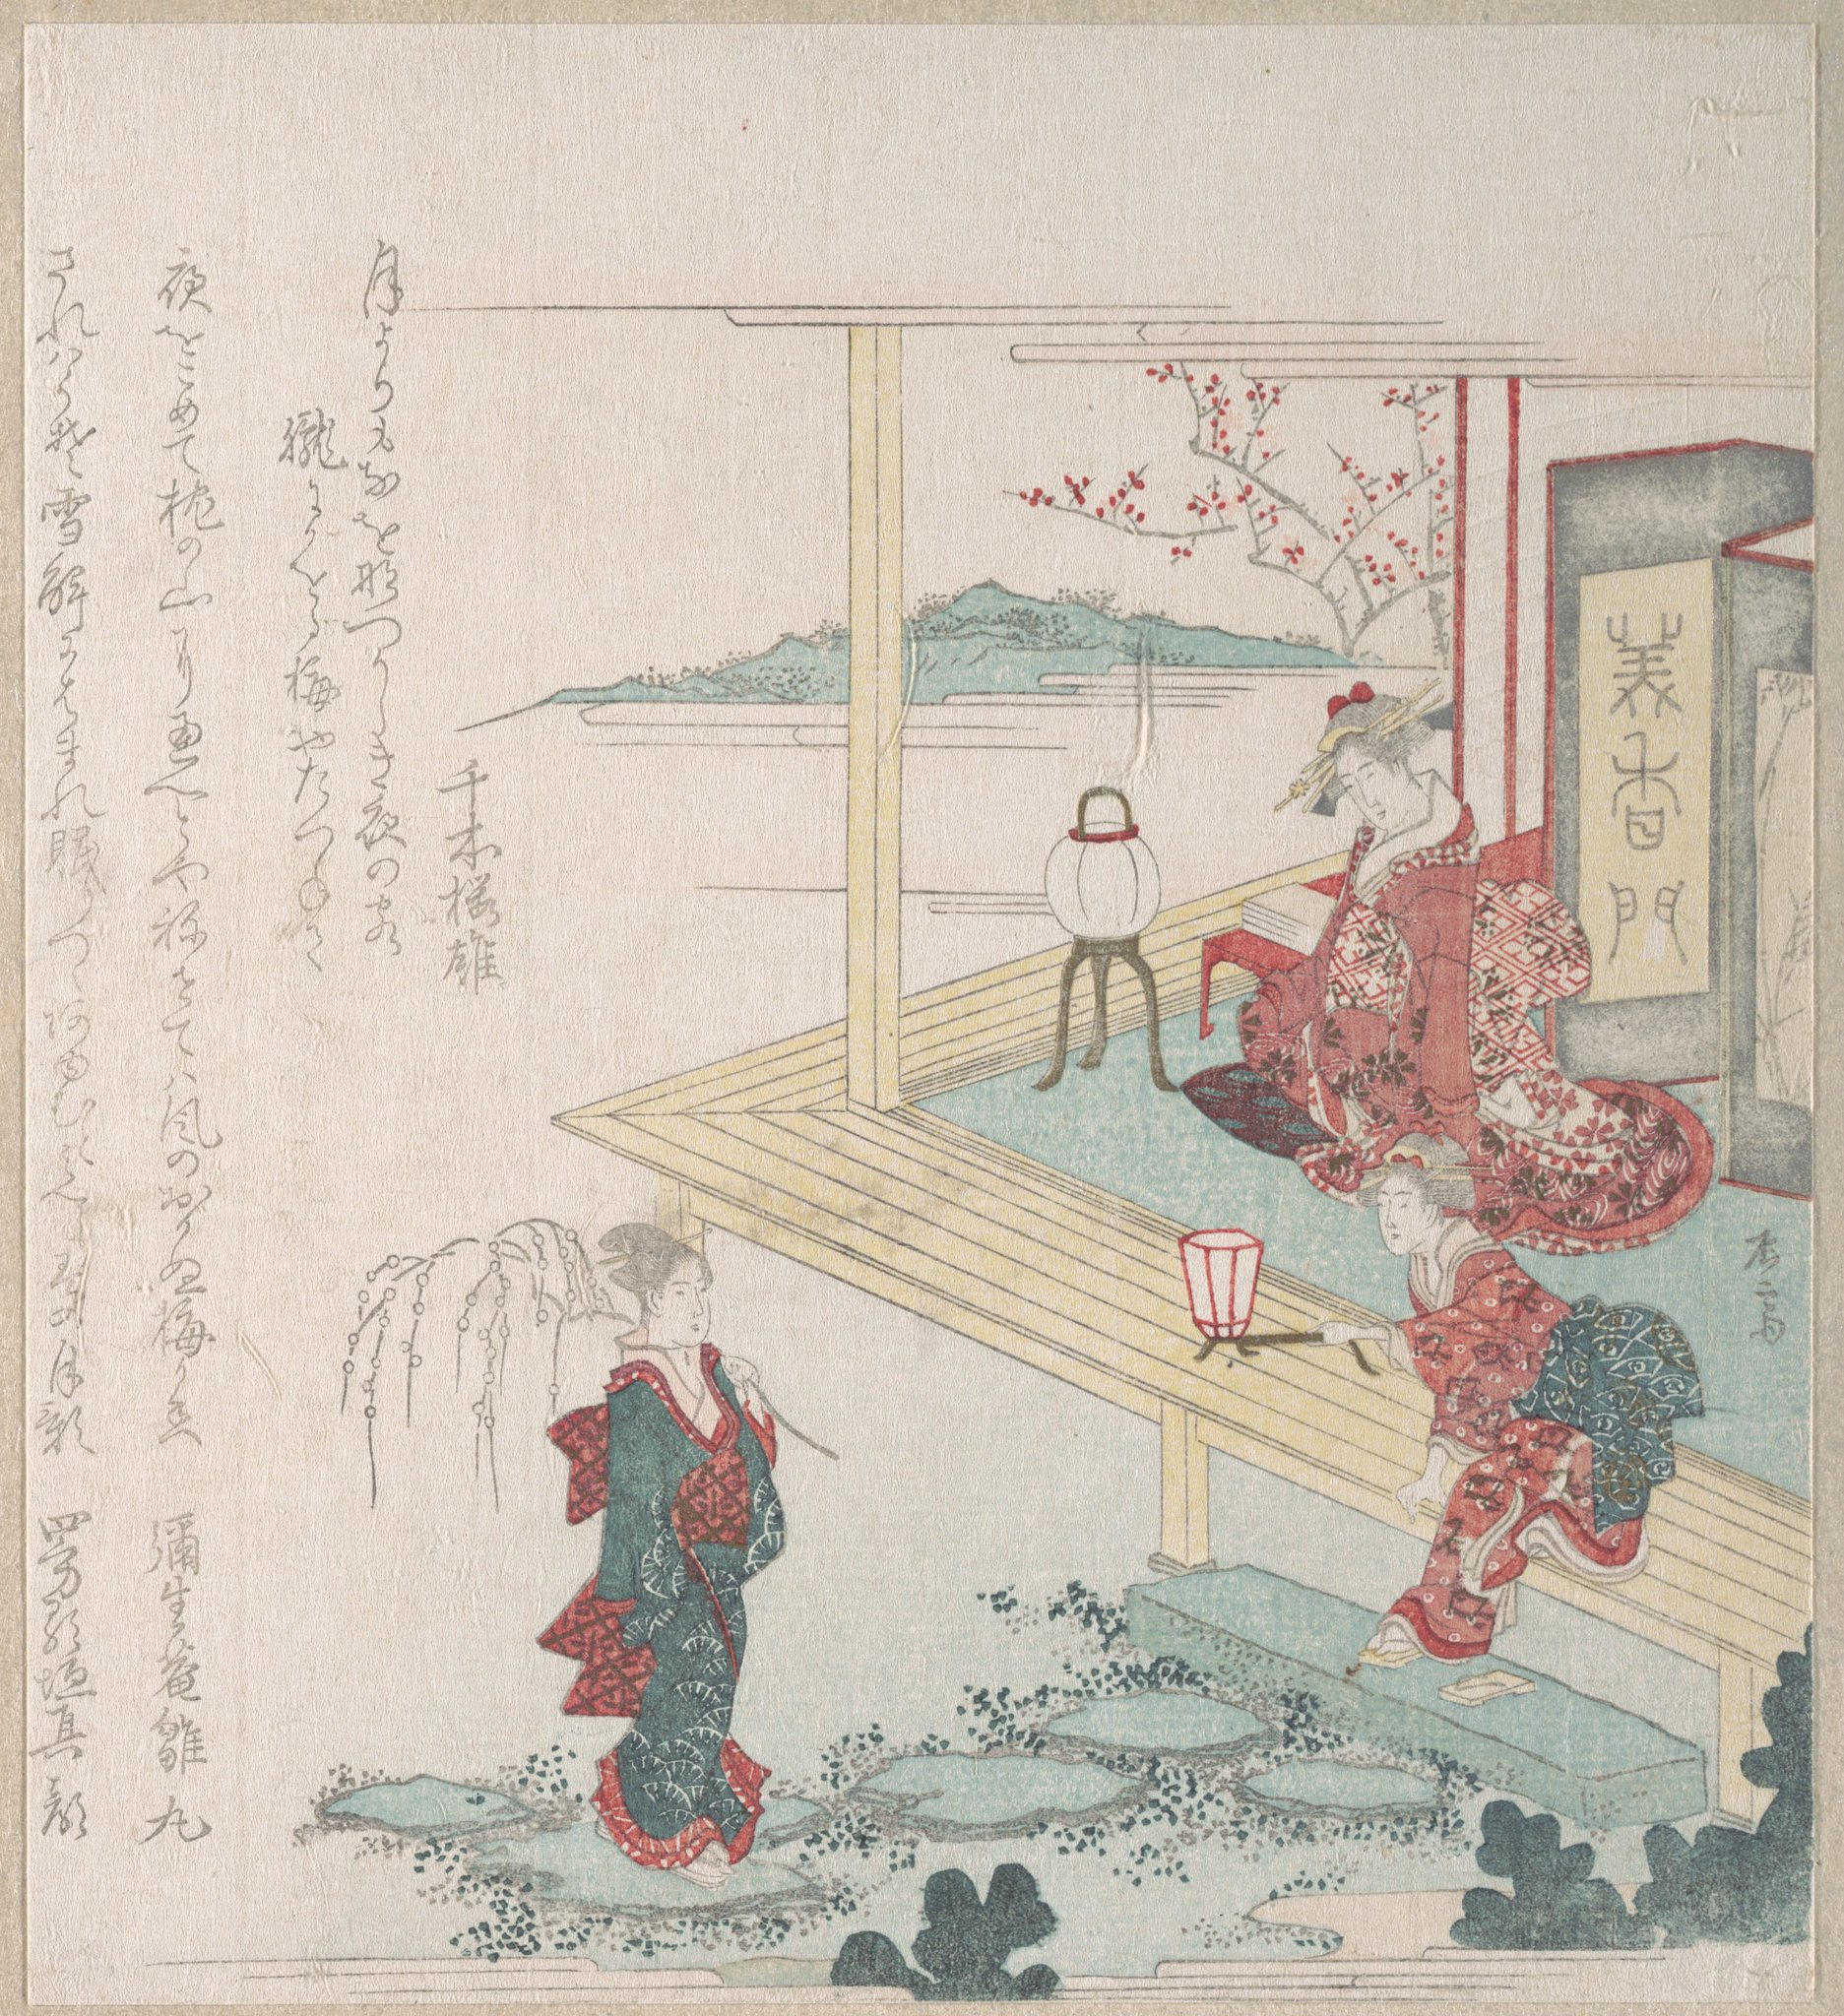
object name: print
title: Right View of a Garden with Three Female Figures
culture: japanese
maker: ryūryūkyo shinsai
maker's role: artist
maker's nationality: japanese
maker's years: 1799-1823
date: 1801-1900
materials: ink, paper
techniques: surimono, woodblock print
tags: women,rivers,mountains